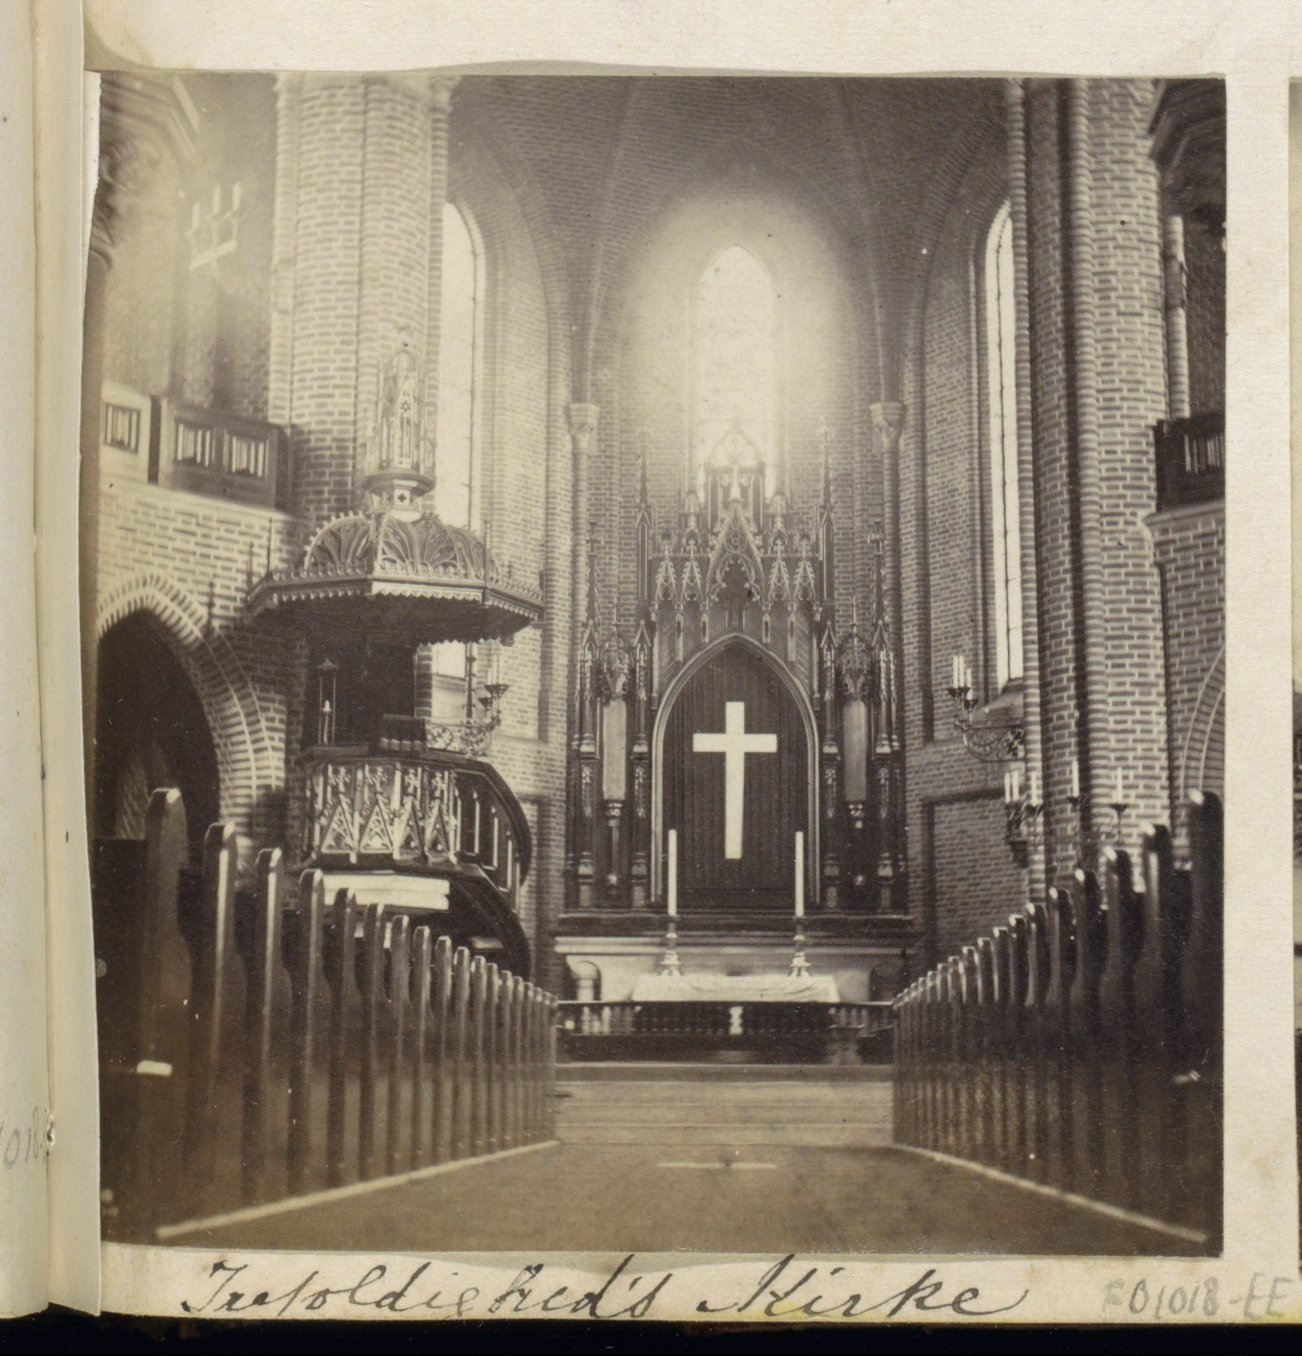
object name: photograph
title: Noorwegen, Trefoldished's Kirke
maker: Anonymous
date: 1860-1870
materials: paper, photographic support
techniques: albumen print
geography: christiania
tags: the cross ~ symbols of christ, parts of church interior: nave, pulpit, ambo, chancel, parts of church interior: choir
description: Onderdeel van Engels familiealbum met foto's van personen, reizen, cricket en kunstwerken.